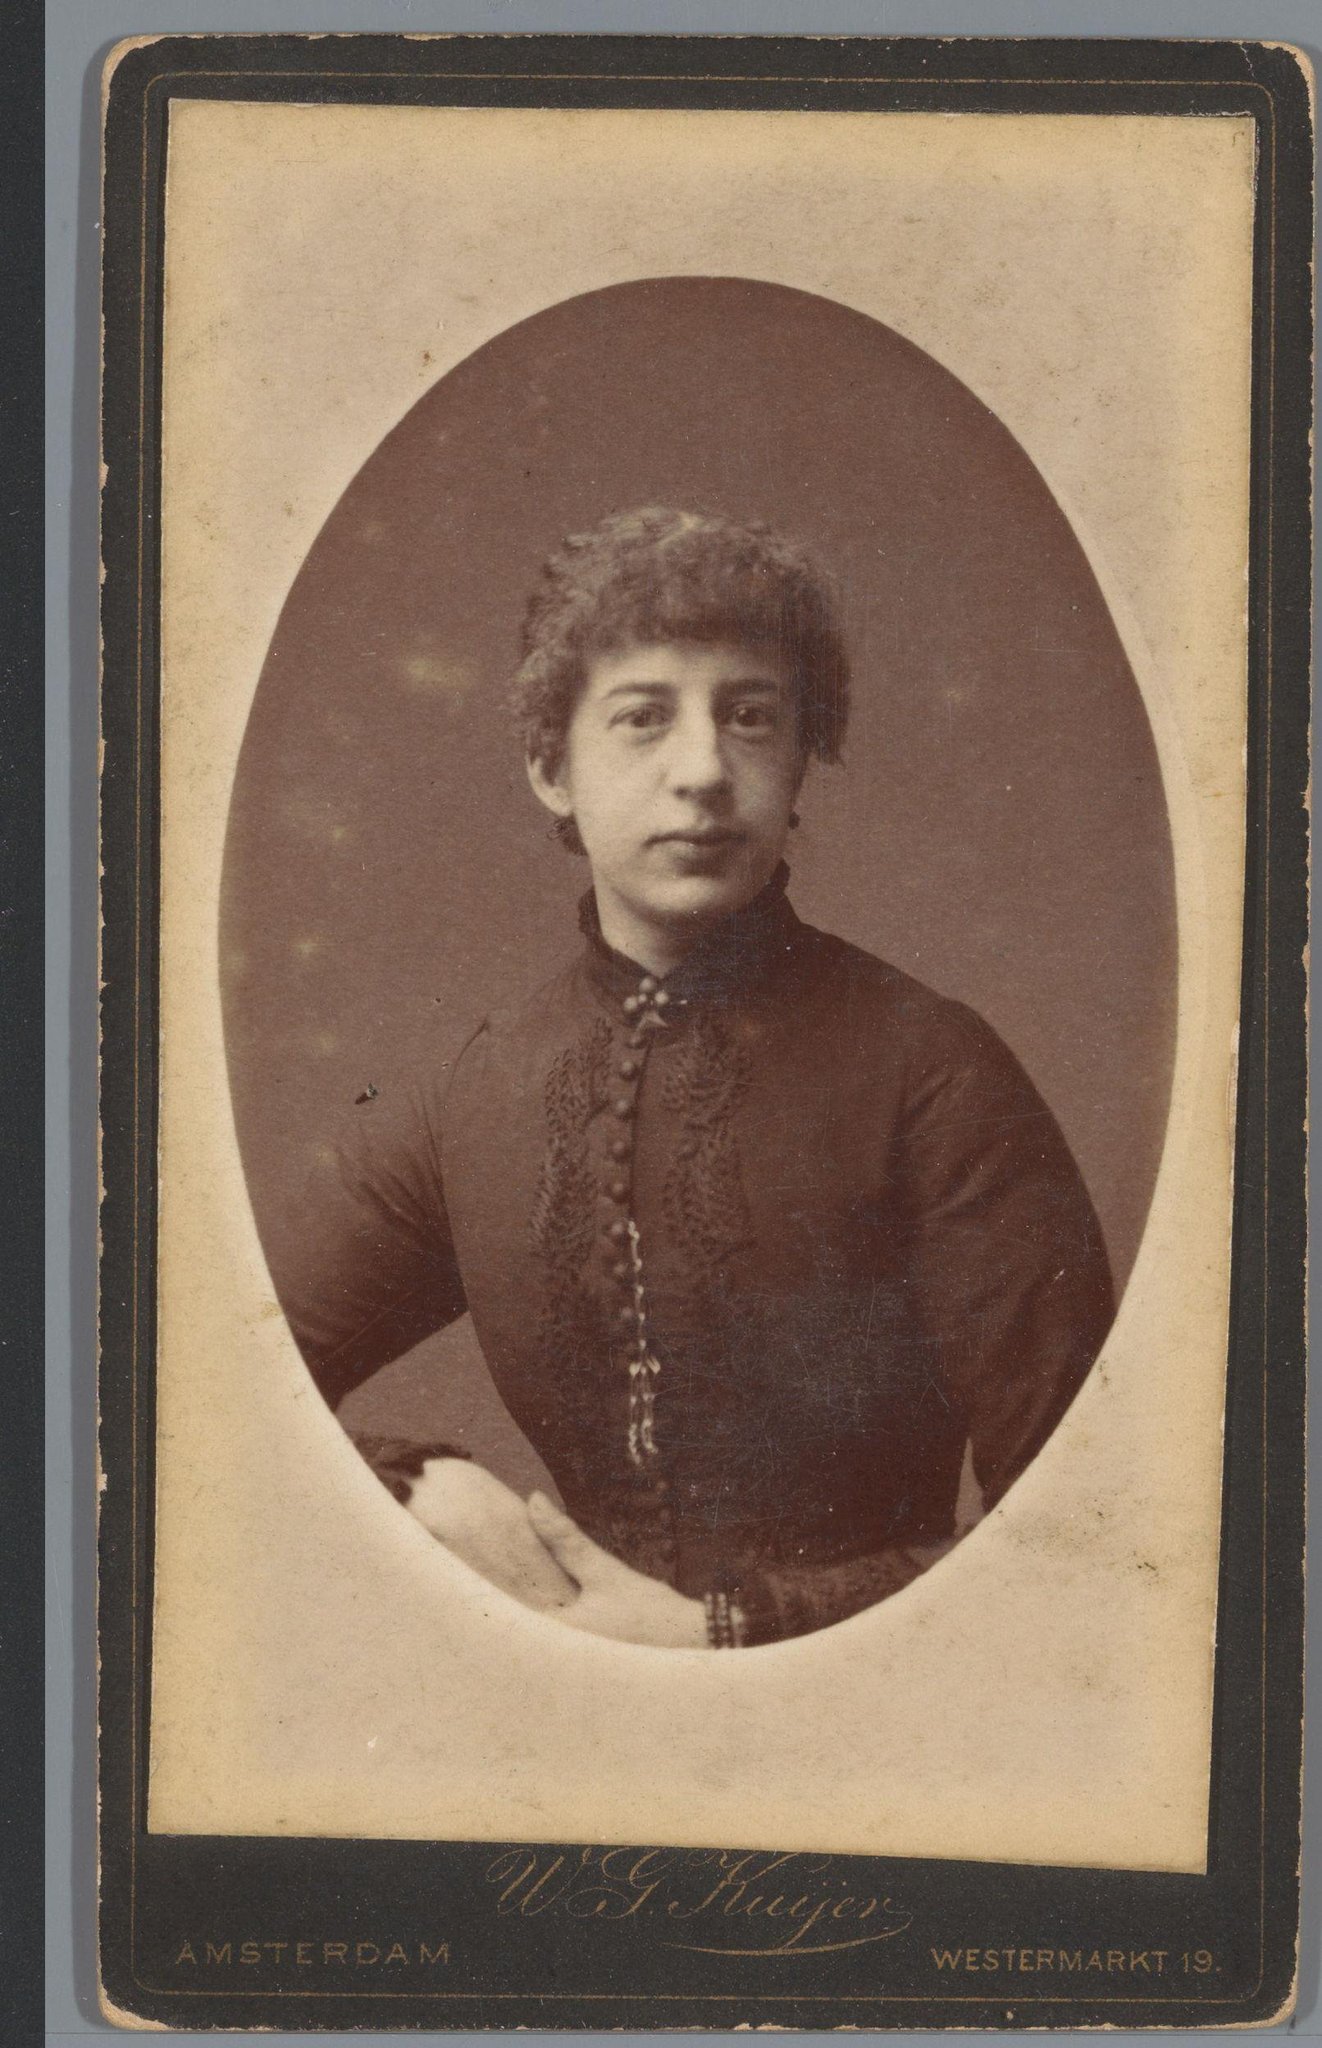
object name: photograph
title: Portret van vermoedelijk een onbekende man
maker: willem gerhardus kuijer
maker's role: fotograaf, hoffotograaf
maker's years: 1834-1899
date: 1862-1899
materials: cardboard, paper, photographic support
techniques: albumen print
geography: amsterdam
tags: adult man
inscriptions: name: ‘W.G. Kuijer Amsterdam Westermarkt 19’, name: ‘Photografisch Atelier van W.G. Kuijer Westermarkt 19 (voorheen Rozengracht 72) Amsterdam.’